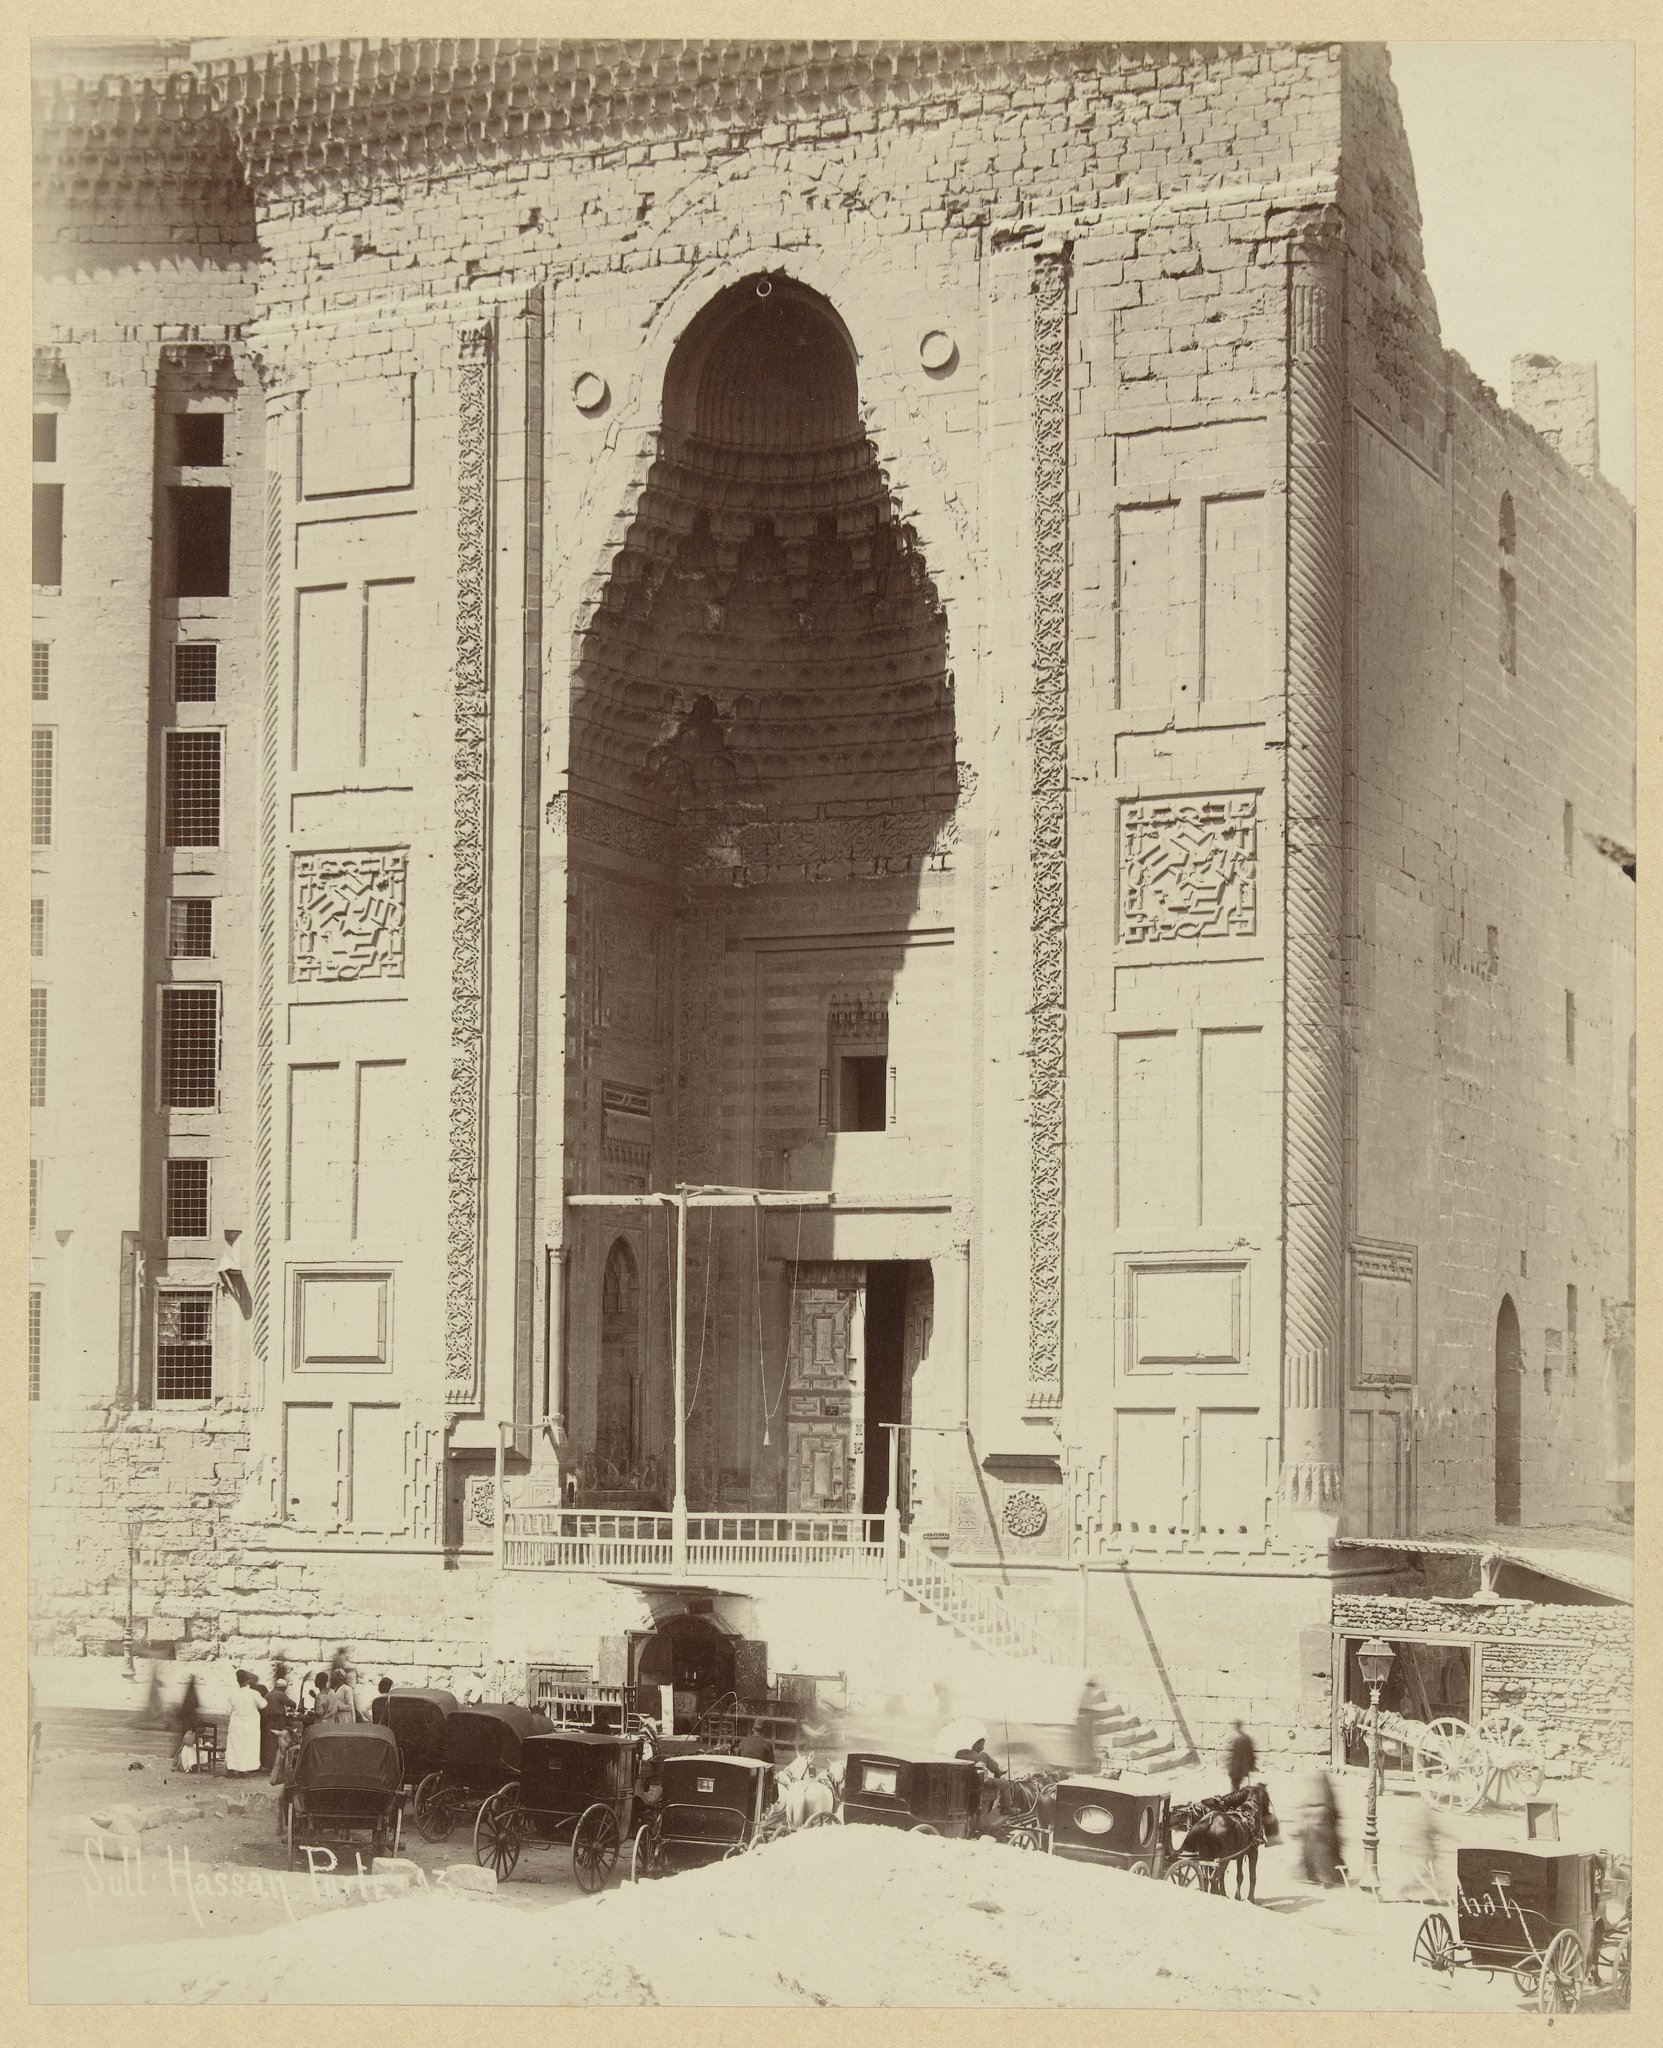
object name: photograph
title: Ingang van de sultan Hassan-moskee, Caïro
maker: jean pascal sébah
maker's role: fotograaf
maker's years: 1872-1947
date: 1888-1895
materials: cardboard, paper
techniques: albumen print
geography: cairo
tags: gate, entrance, temple, shrine ~ islam, mohammedanism, mosque-madrasa of sultan hassan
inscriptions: check stamp: ‘Bristol/ L.M.’, number: ‘13’, title: ‘E 39. Moskee van Sultan Hassan (ingang). Caïro.’, stamp: ‘Gemeentelijke bibliotheek/ Rotterdam’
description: Onderdeel van een groep door fotograaf Richard Polak op reis verzamelde foto’s. Deze foto is samen met andere op zijn reizen verzamelde foto's tentoongesteld bij de Rotterdamsche Kunstkring (1895), Arti en Amicitiae te Amsterdam (1897-1898?) en Societeit 't Collegie te Kampen (datum vooralsnog onbekend).